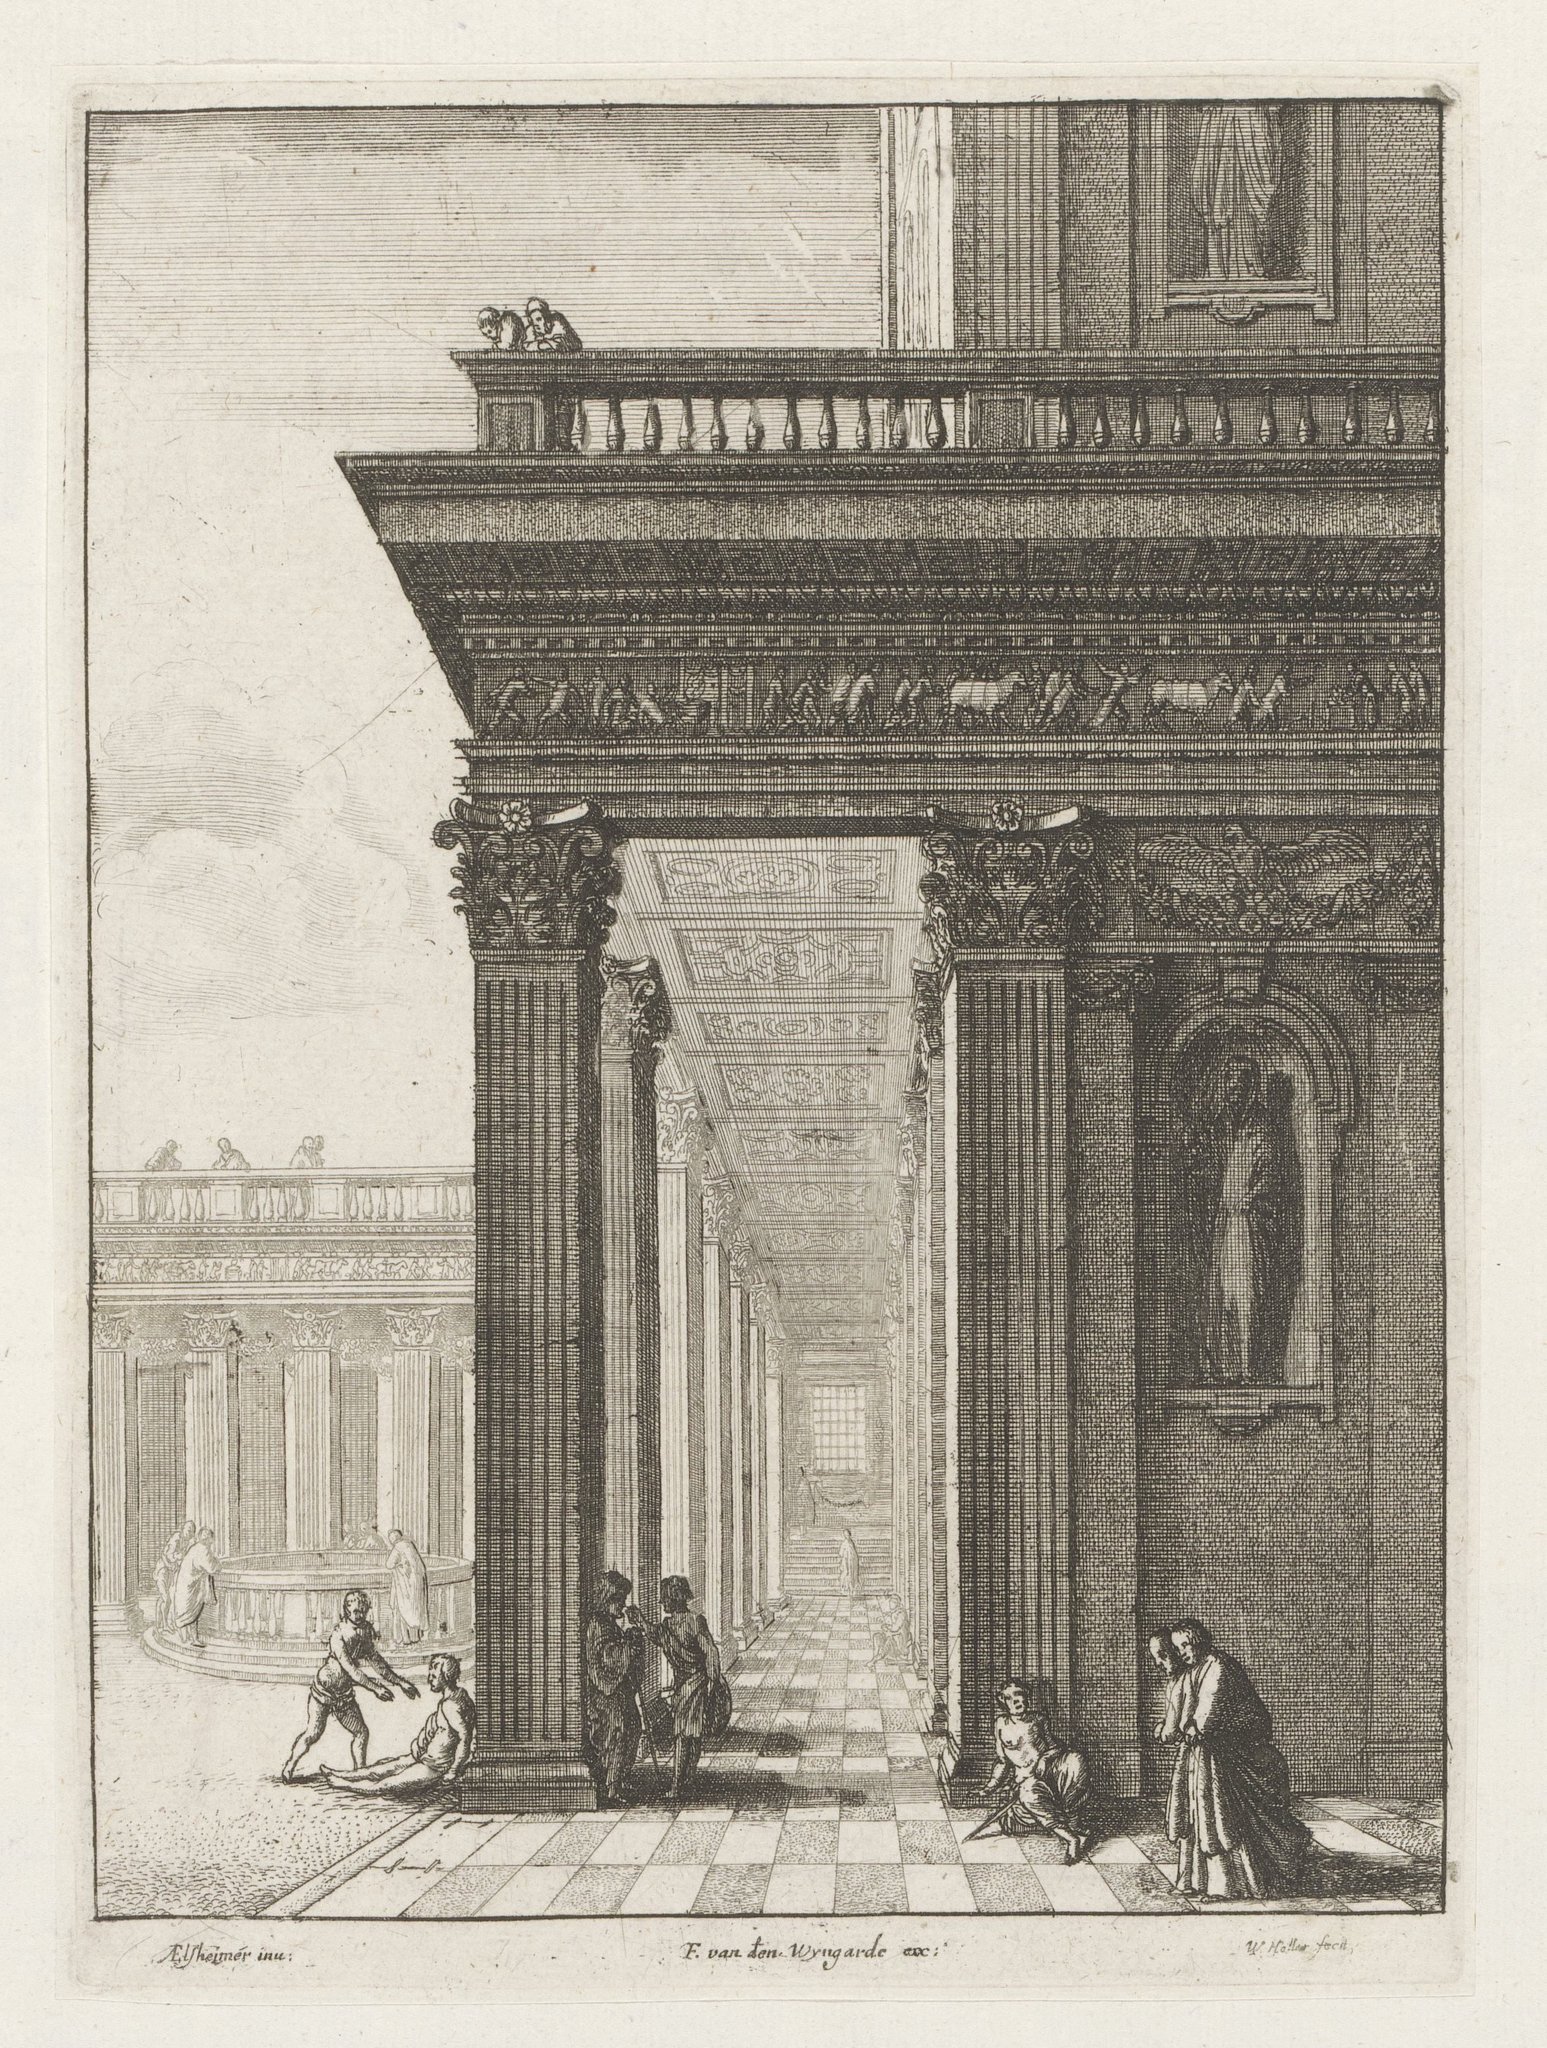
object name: album leaf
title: Magesyn der Italiaense gebouwen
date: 1624-1679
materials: paper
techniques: etching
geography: antwerp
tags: palace, inner court of palace or 'hôtel'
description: Deze prent is naar een tekening door David Teniers I die wordt bewaard in het Metropolitan Museum of Art in New York (inv. nr.: 2001.280).